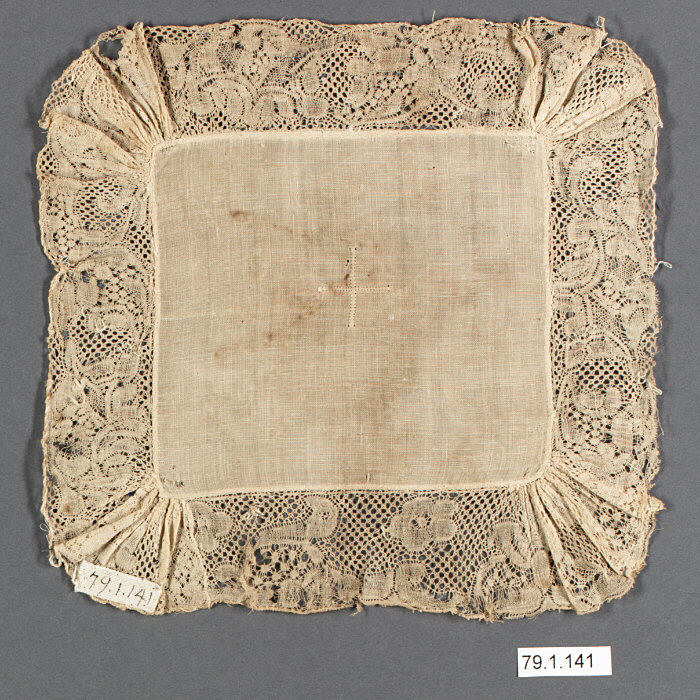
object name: square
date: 1701-1800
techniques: lace